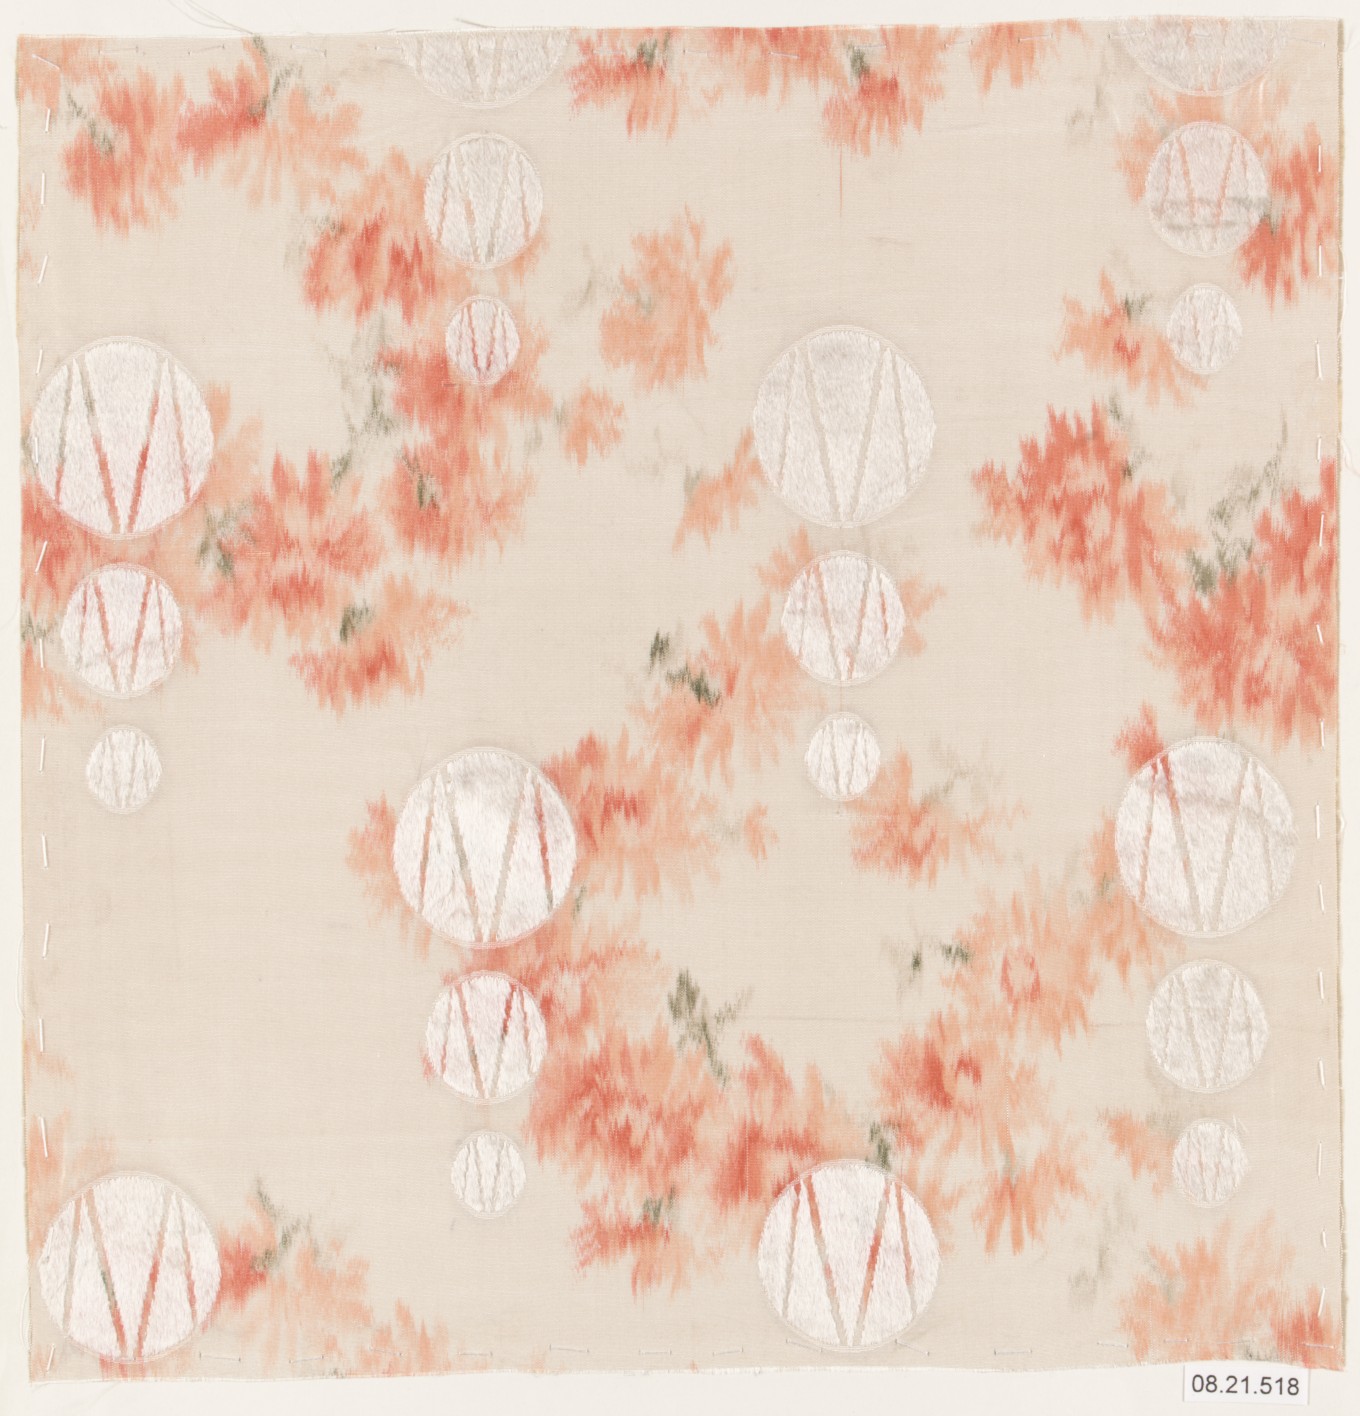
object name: textile sample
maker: Anonymous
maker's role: designer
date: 1900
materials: silk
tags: flowers